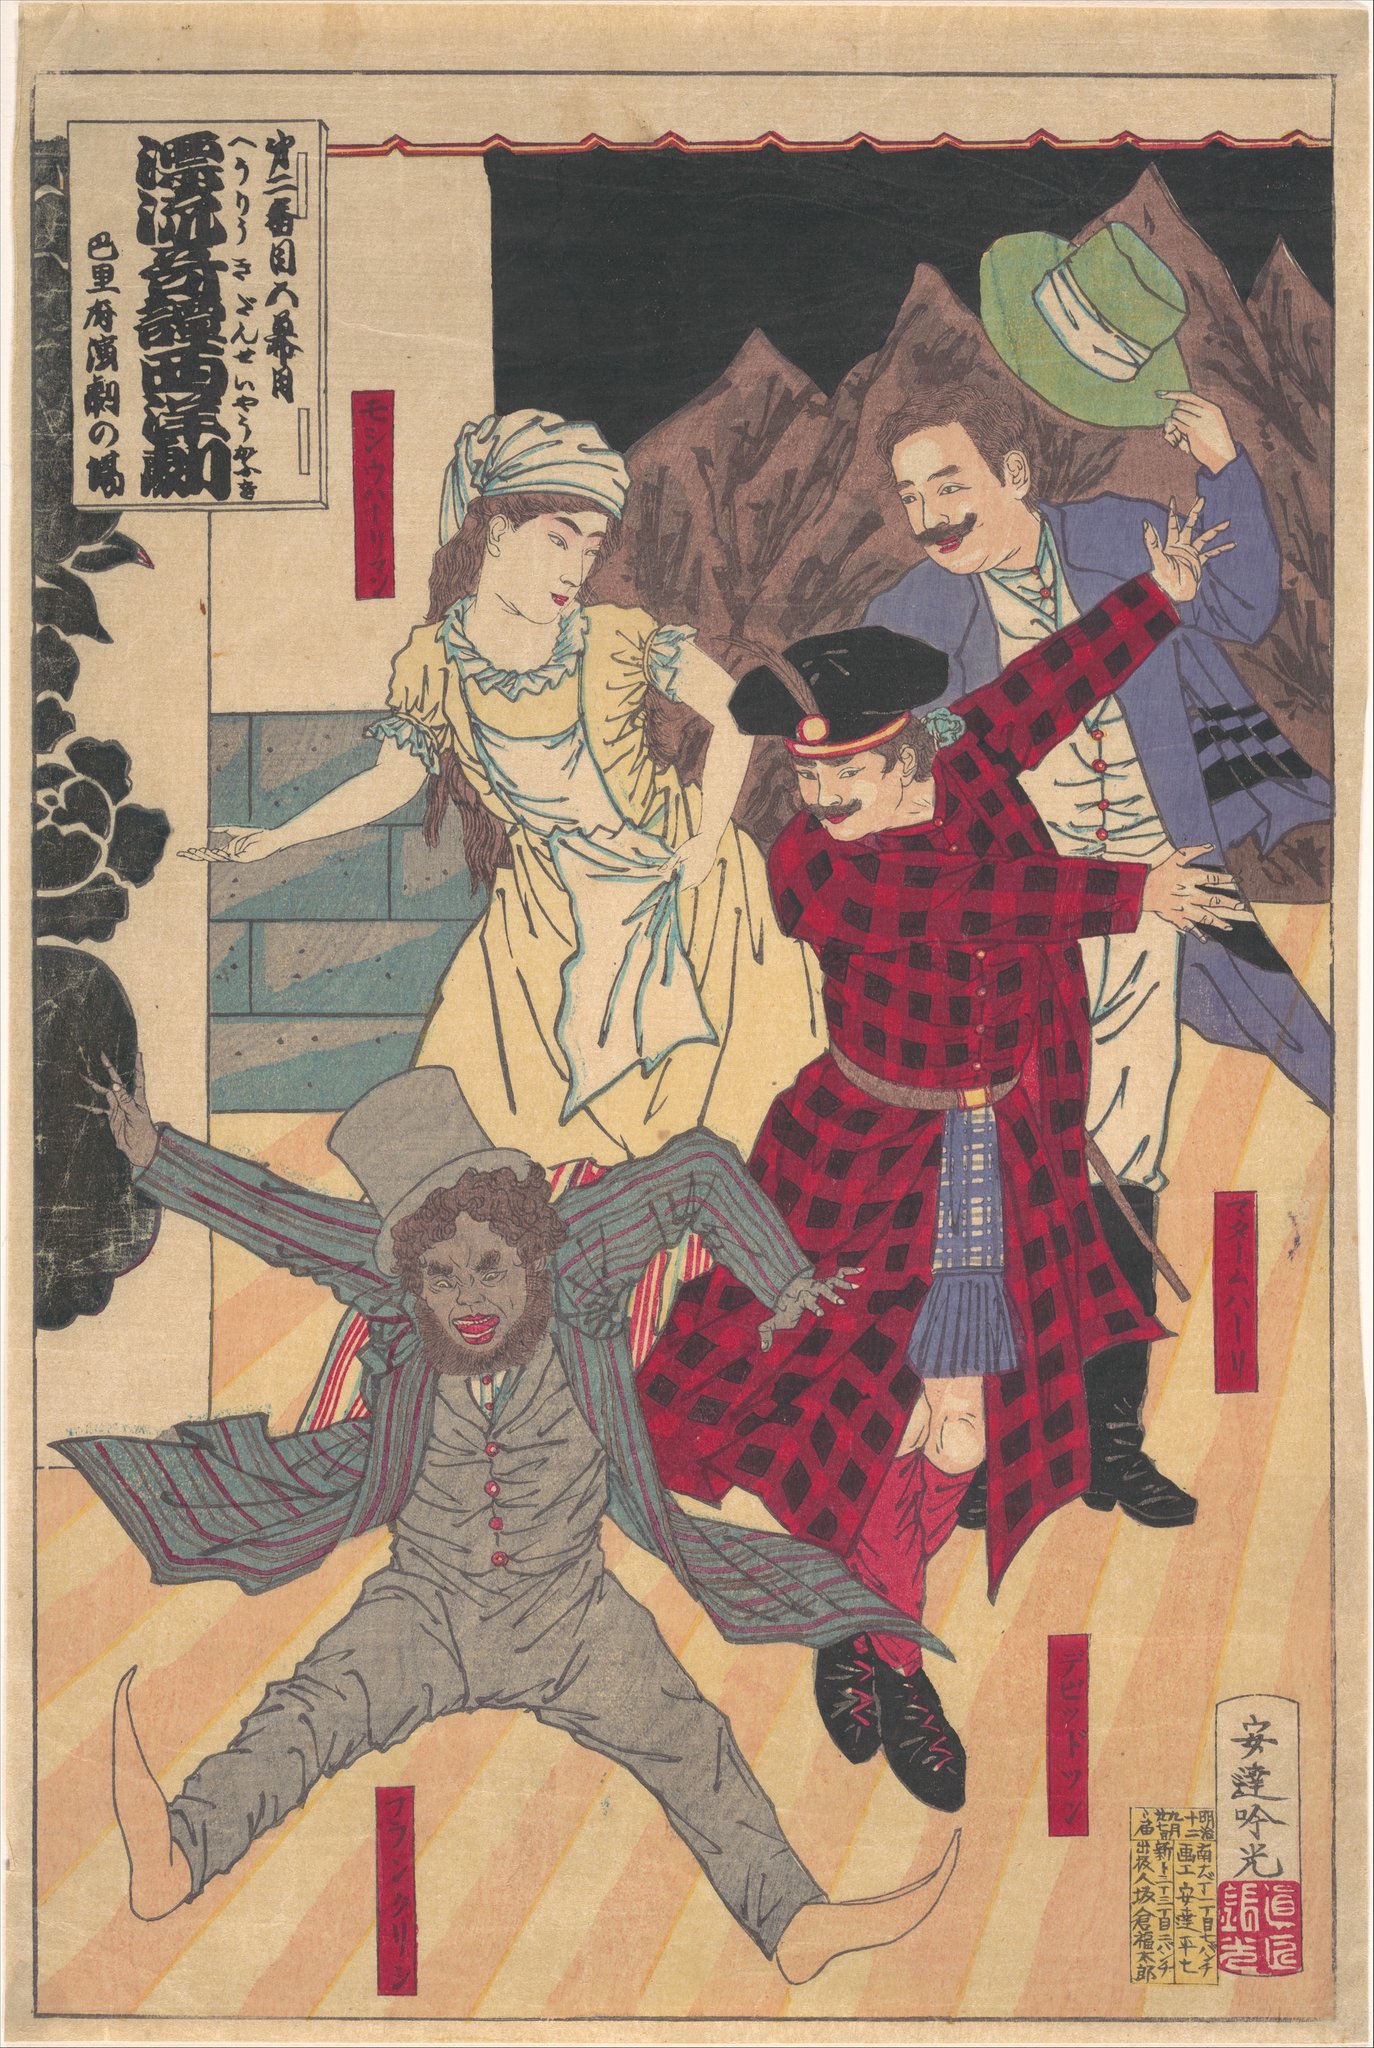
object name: print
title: “Act II, Scene 5: At the Opera in Paris,” from the series The Strange Tale of the Castaways: A Western Kabuki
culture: japanese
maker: adachi ginkō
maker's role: artist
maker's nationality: japanese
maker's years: 1853-1902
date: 1879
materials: ink, paper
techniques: nishiki e, woodblock print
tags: men,women